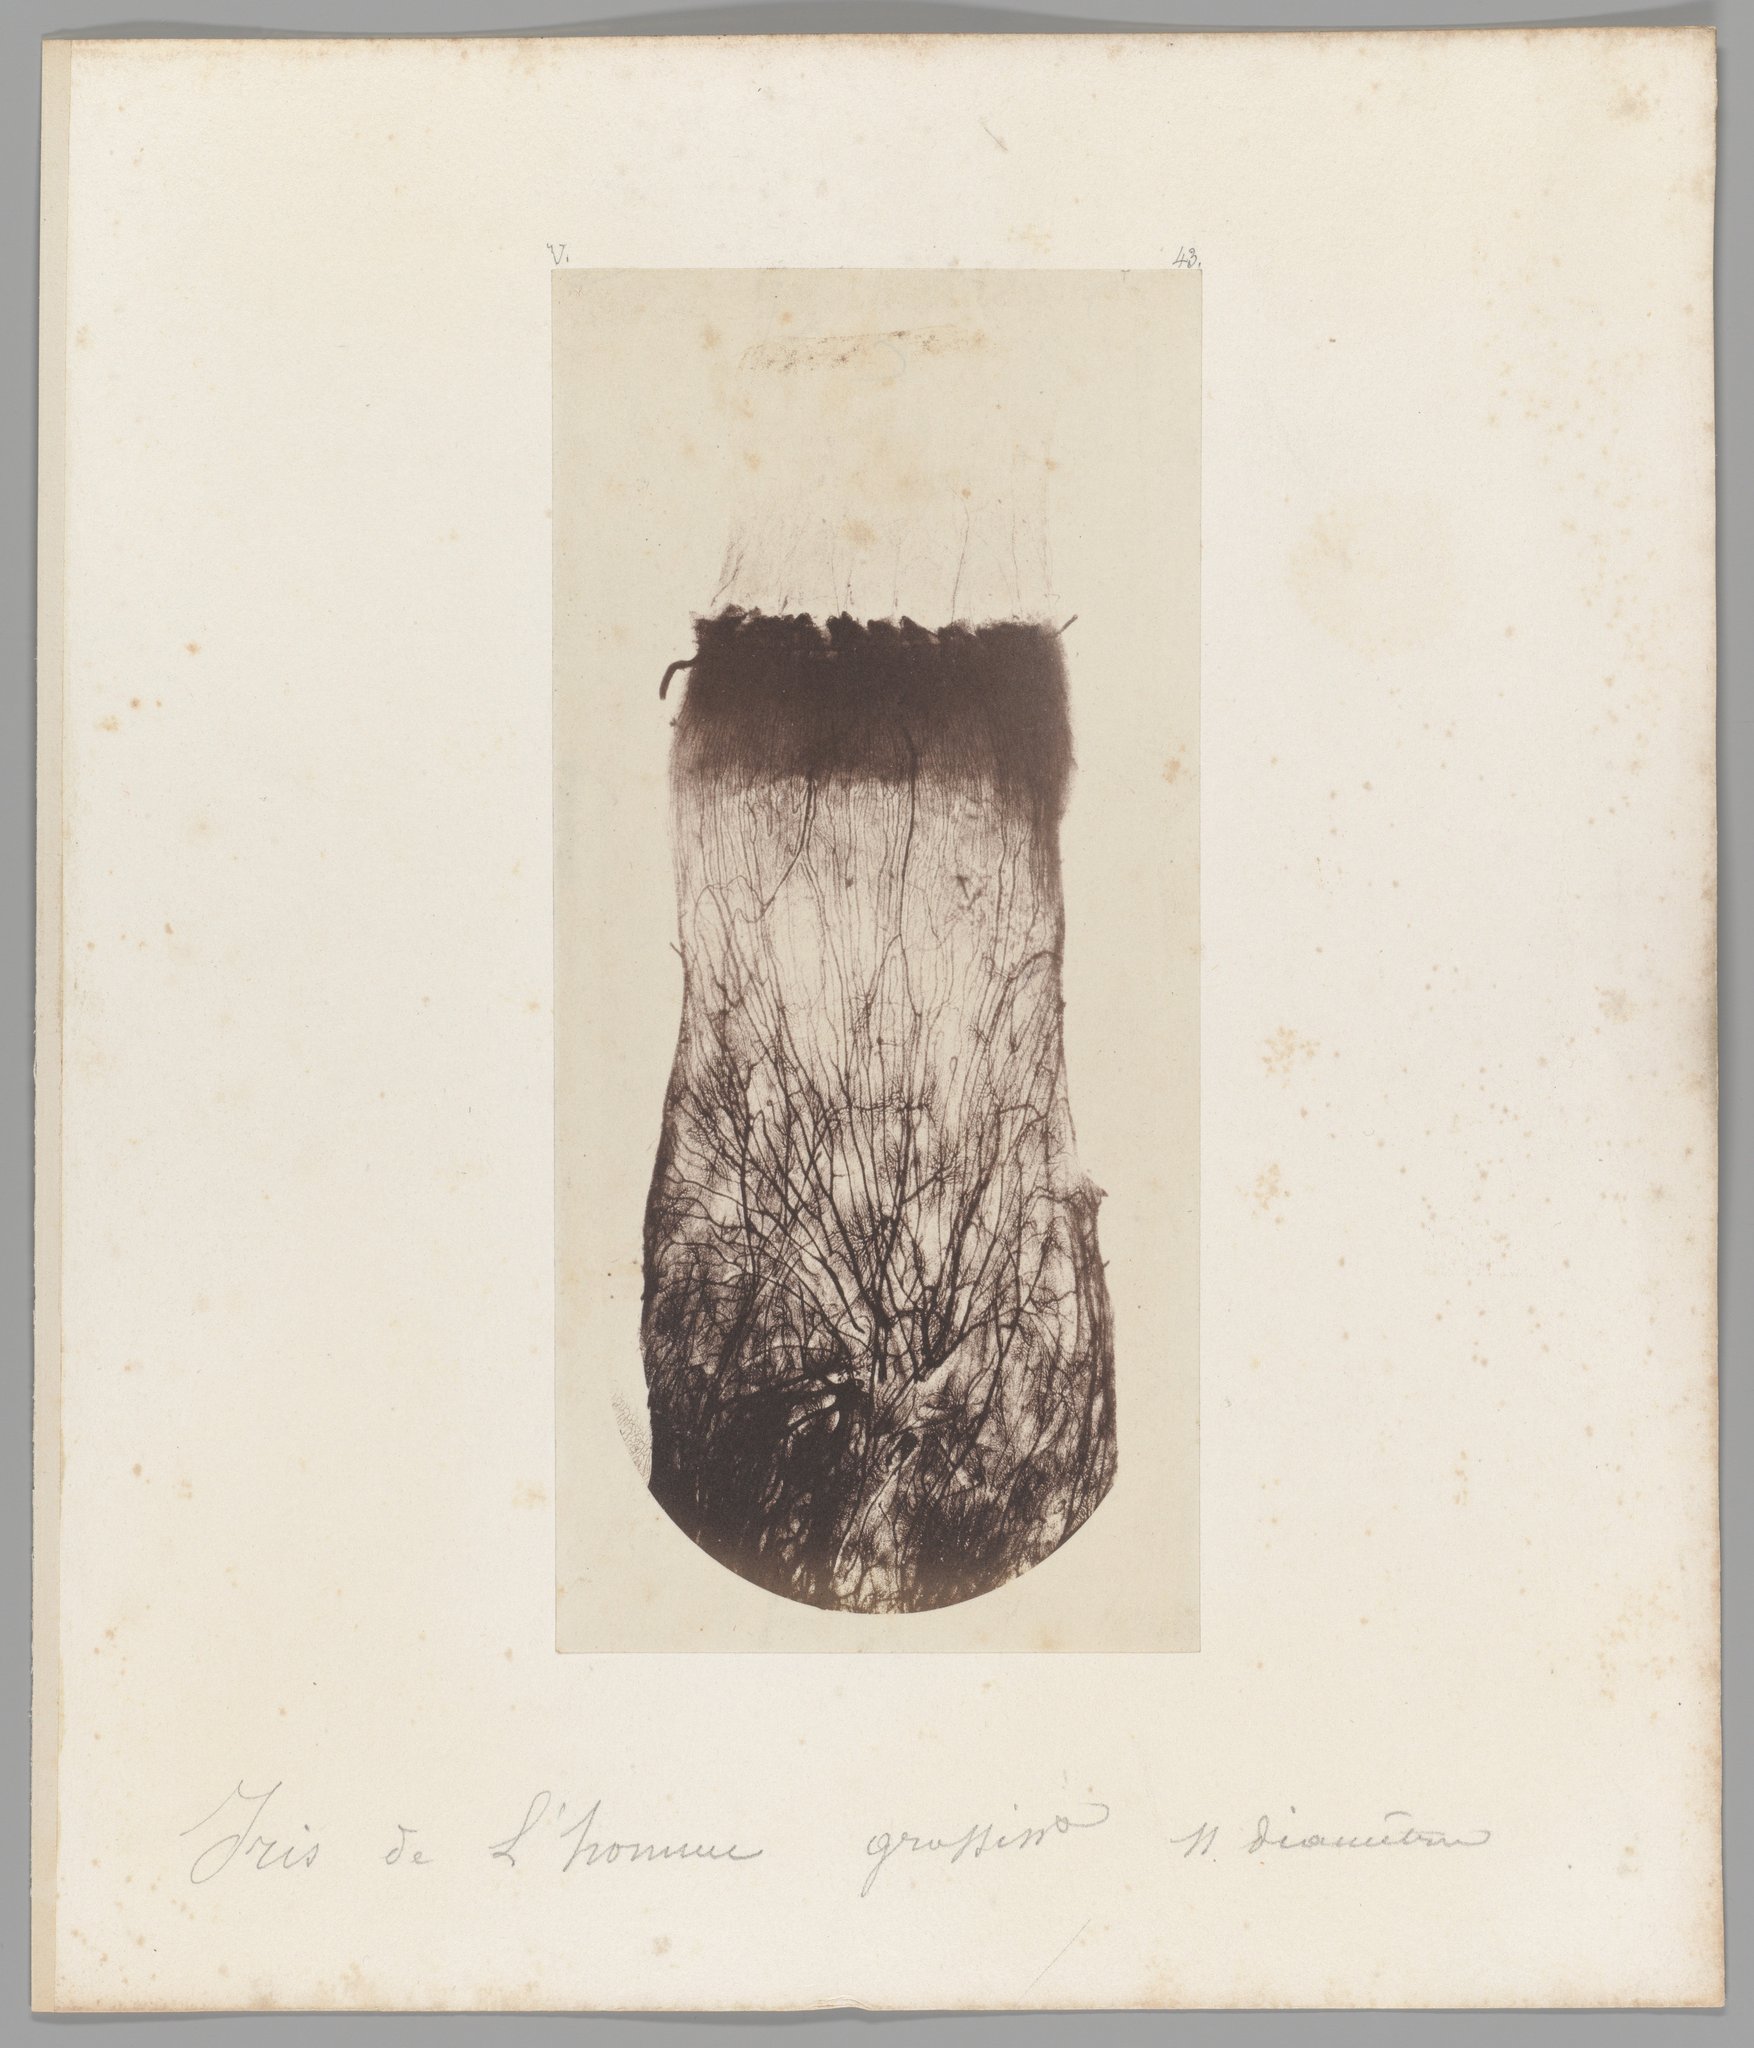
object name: photograph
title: [Untitled]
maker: auguste-adolphe bertsch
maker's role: artist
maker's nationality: french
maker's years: 1813-1871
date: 1853-1857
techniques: salted paper print